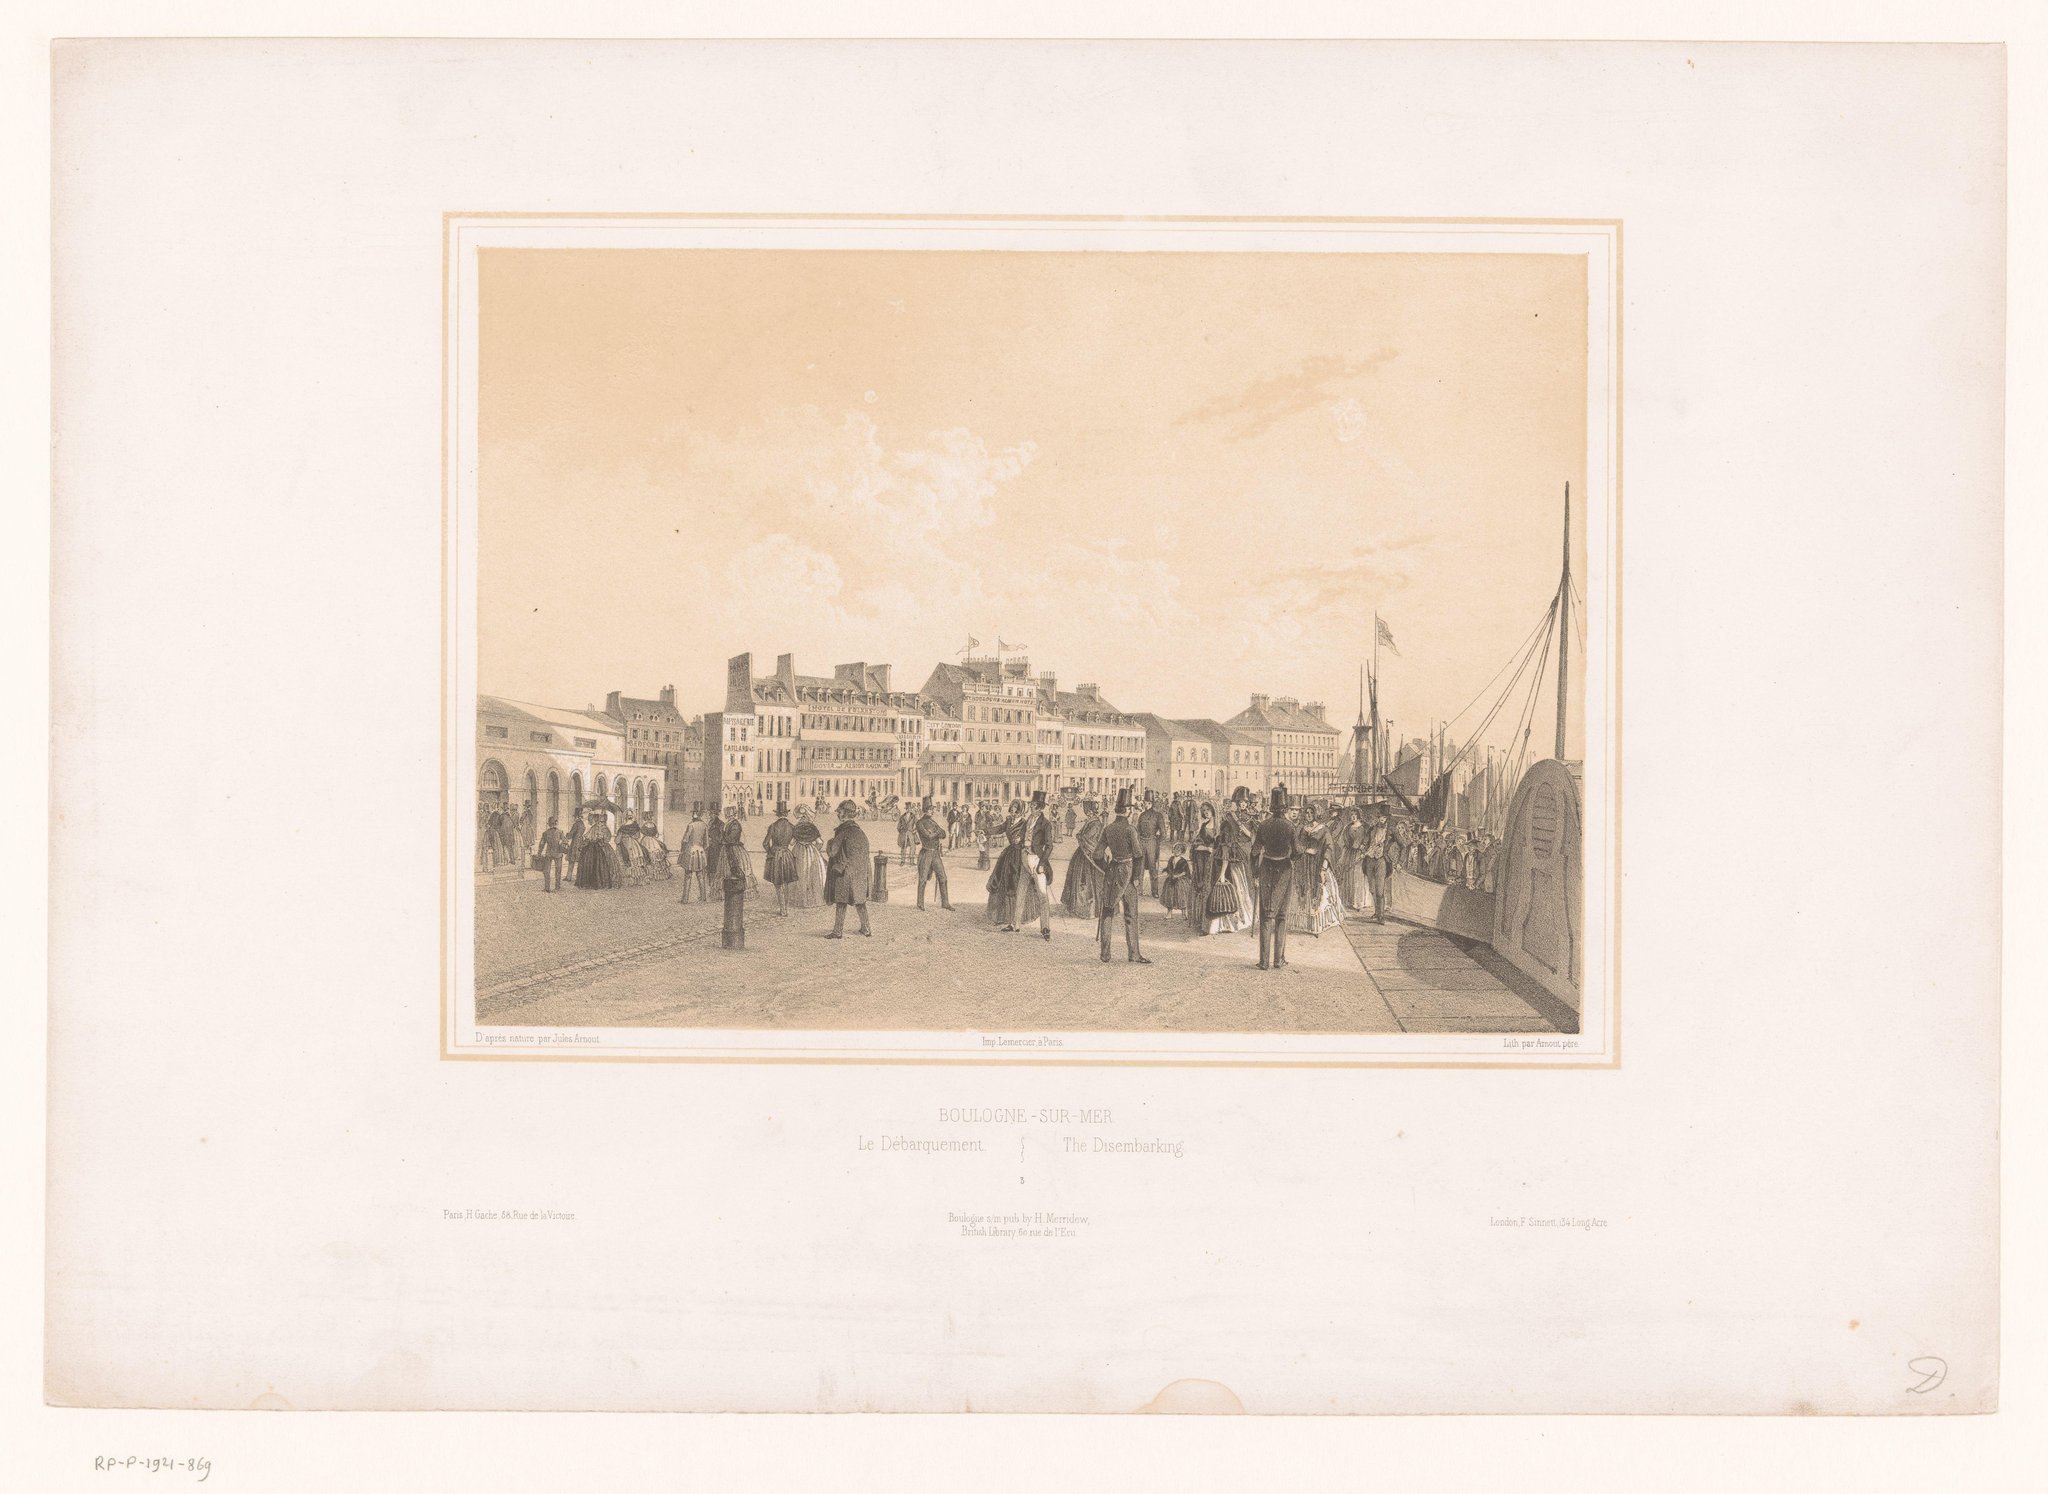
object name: print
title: Le Dèbarquement / The Disembarking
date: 1847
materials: paper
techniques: tone lithography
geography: paris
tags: harbour, pier, quay, wharf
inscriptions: check stamp: Lugt 3977, collector's mark: Lugt 2233, collector's mark: Lugt 2228